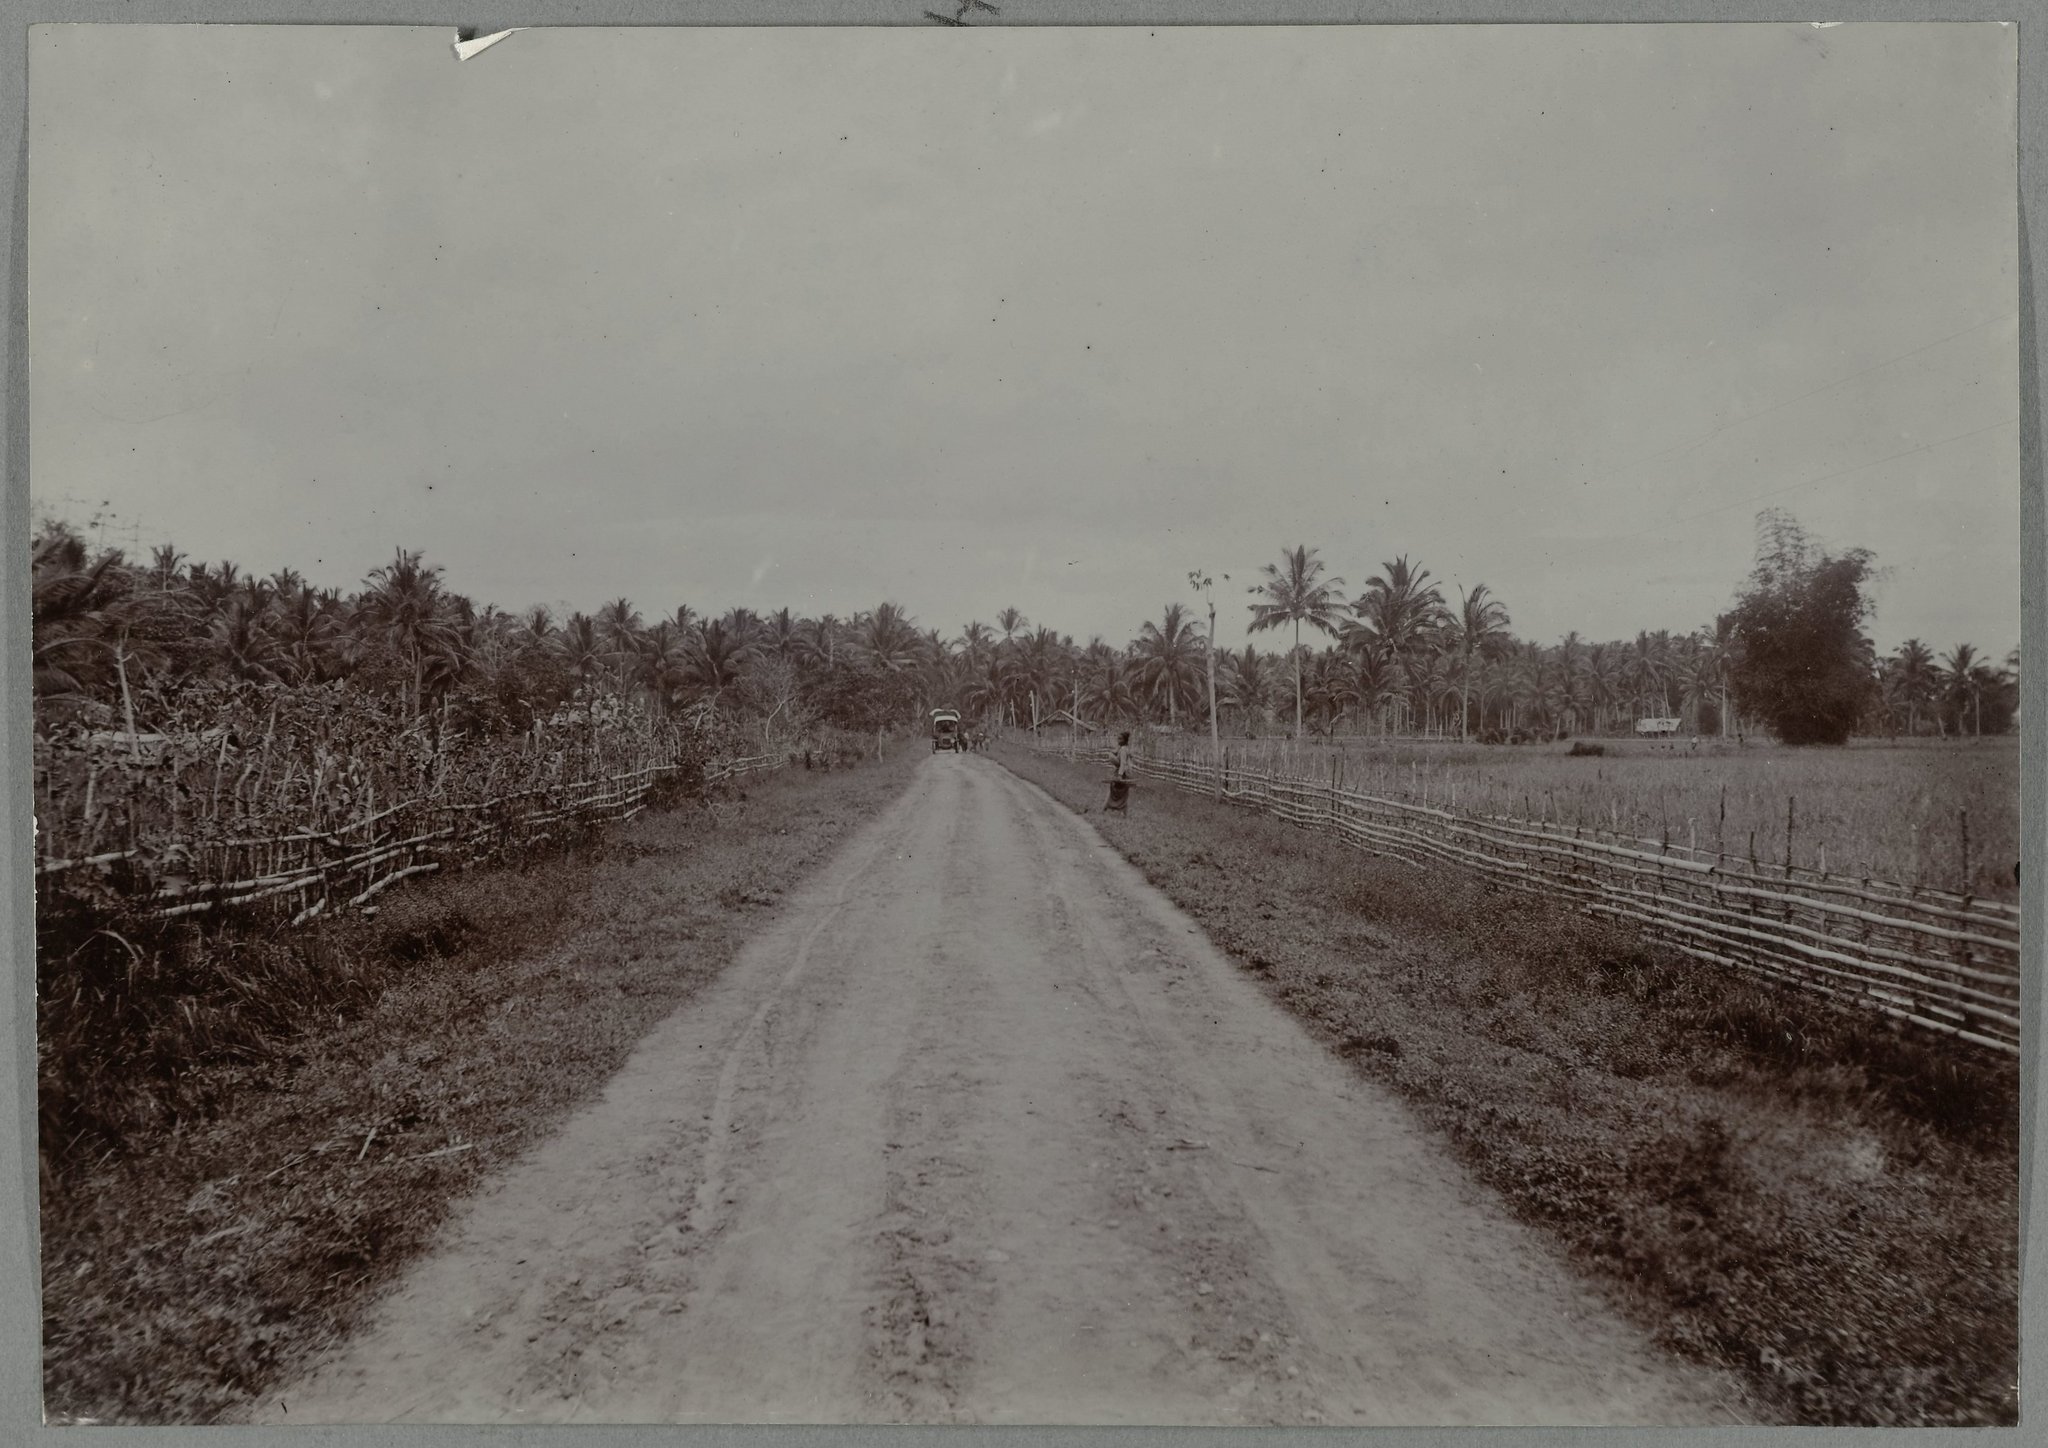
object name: photograph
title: Begin van de Gajoweg bij Bireuen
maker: Anonymous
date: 1903-1913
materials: photographic support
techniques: photography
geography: north sumatra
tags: arnhem, albertus dominicus laman trip, building activities, traffic by road or path with motor-vehicle, landscapes in tropical and sub-tropical regions, road, path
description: Na de expedities naar de Gajo- en Alaslanden o.l.v. Van Daalen (eerste tocht in 1901), werd hij in 1903 belast met voorbereiding van permanente vestiging van Nederlands gezag. Aanleg van een weg van de Noordkust naar het binnenland was hierbij van groot belang. Deze zgn. Gajoweg werd aangelegd tussen 1903 en 1914, van Bireuen aan de kust naar Takinguen aan het bergmeer Danau Lauttawar, totale lente 104 km.